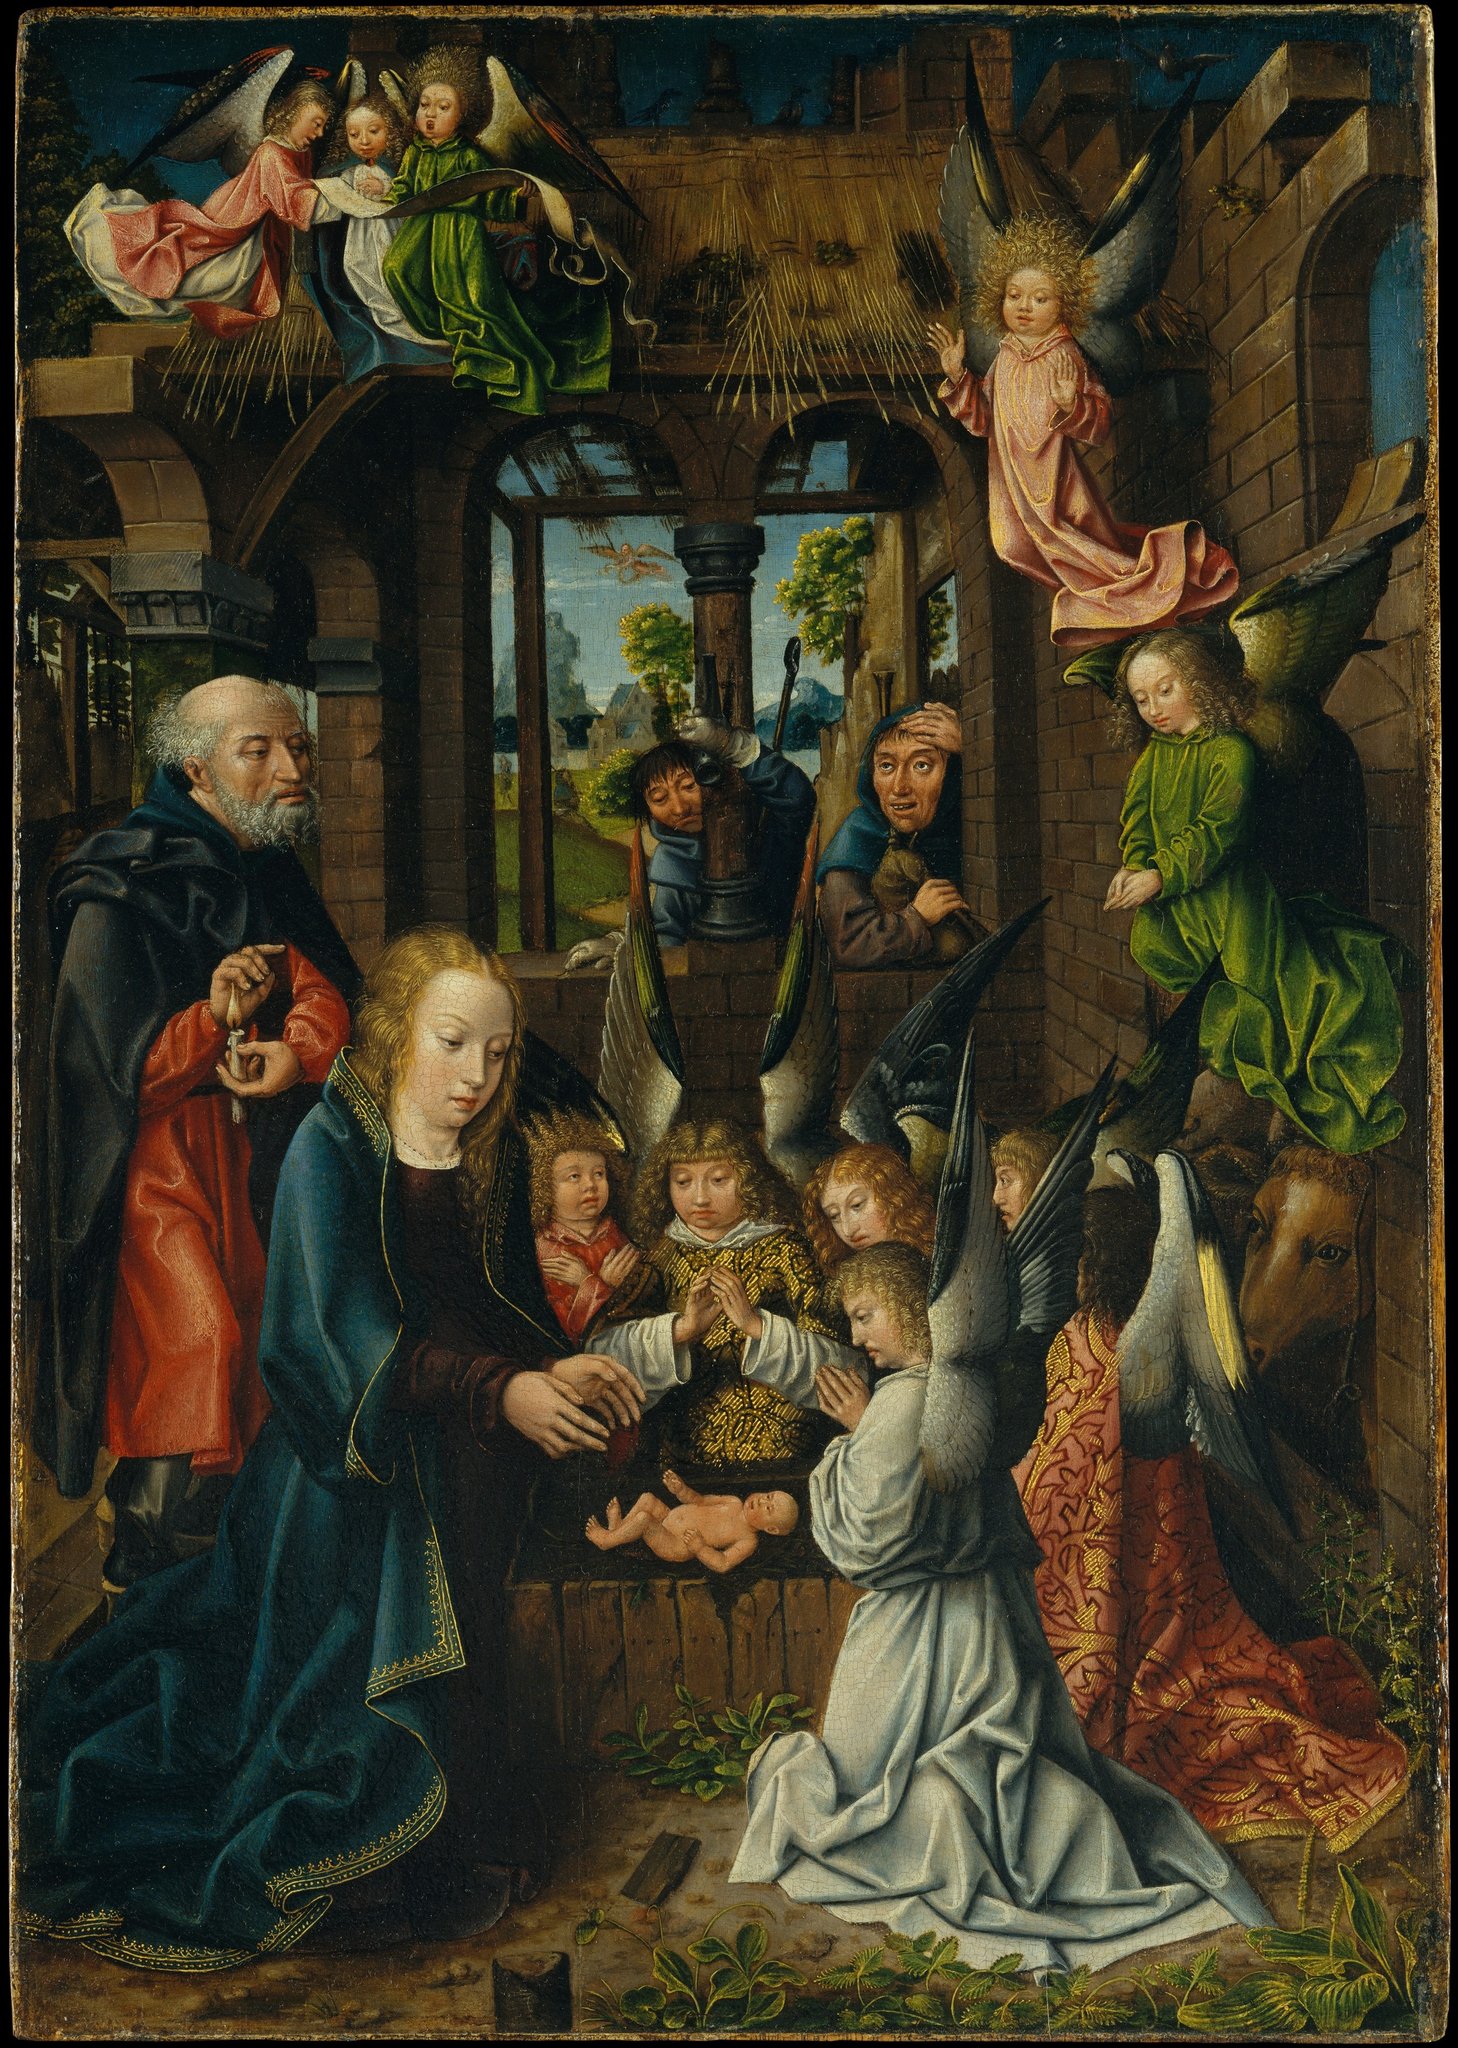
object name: painting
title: The Adoration of the Christ Child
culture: dutch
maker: master of frankfurt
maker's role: artist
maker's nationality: netherlandish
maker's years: 1491-1515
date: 1496-1502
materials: wood, oil, panel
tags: men,angels,virgin mary,jesus